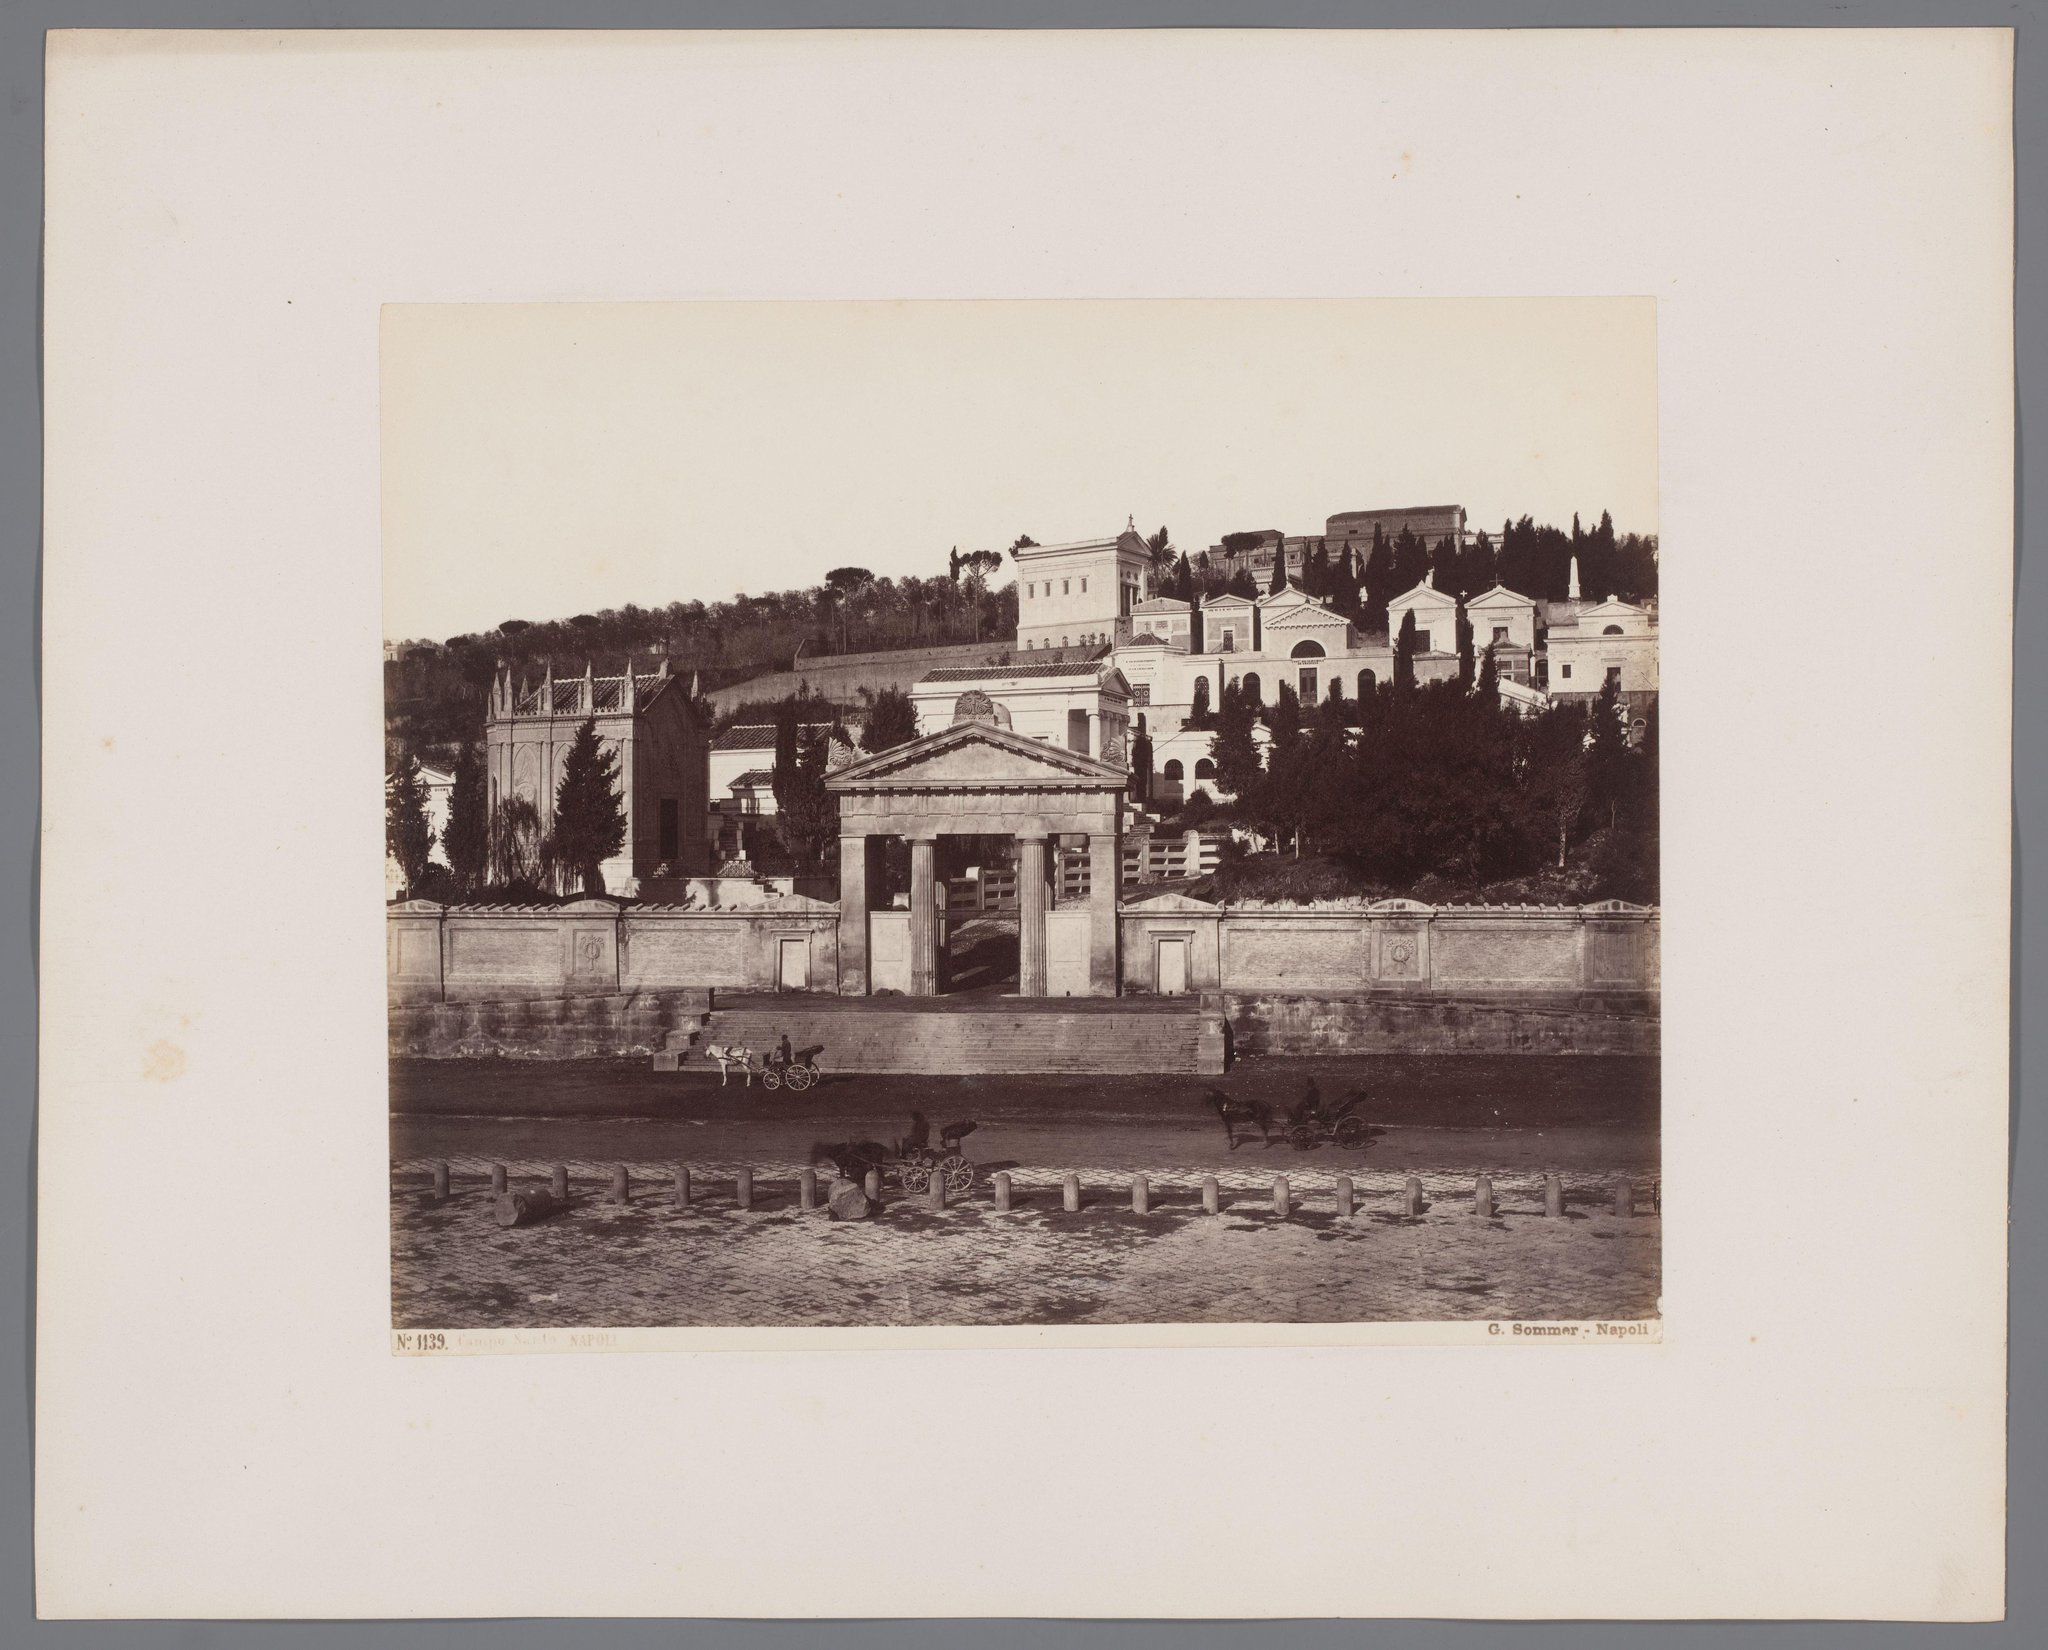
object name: photograph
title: Campo Santo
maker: giorgio sommer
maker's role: fotograaf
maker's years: 1834-1914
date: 1857-1914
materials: cardboard, paper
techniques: albumen print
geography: naples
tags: necropolis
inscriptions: number: ‘No. 1139.’